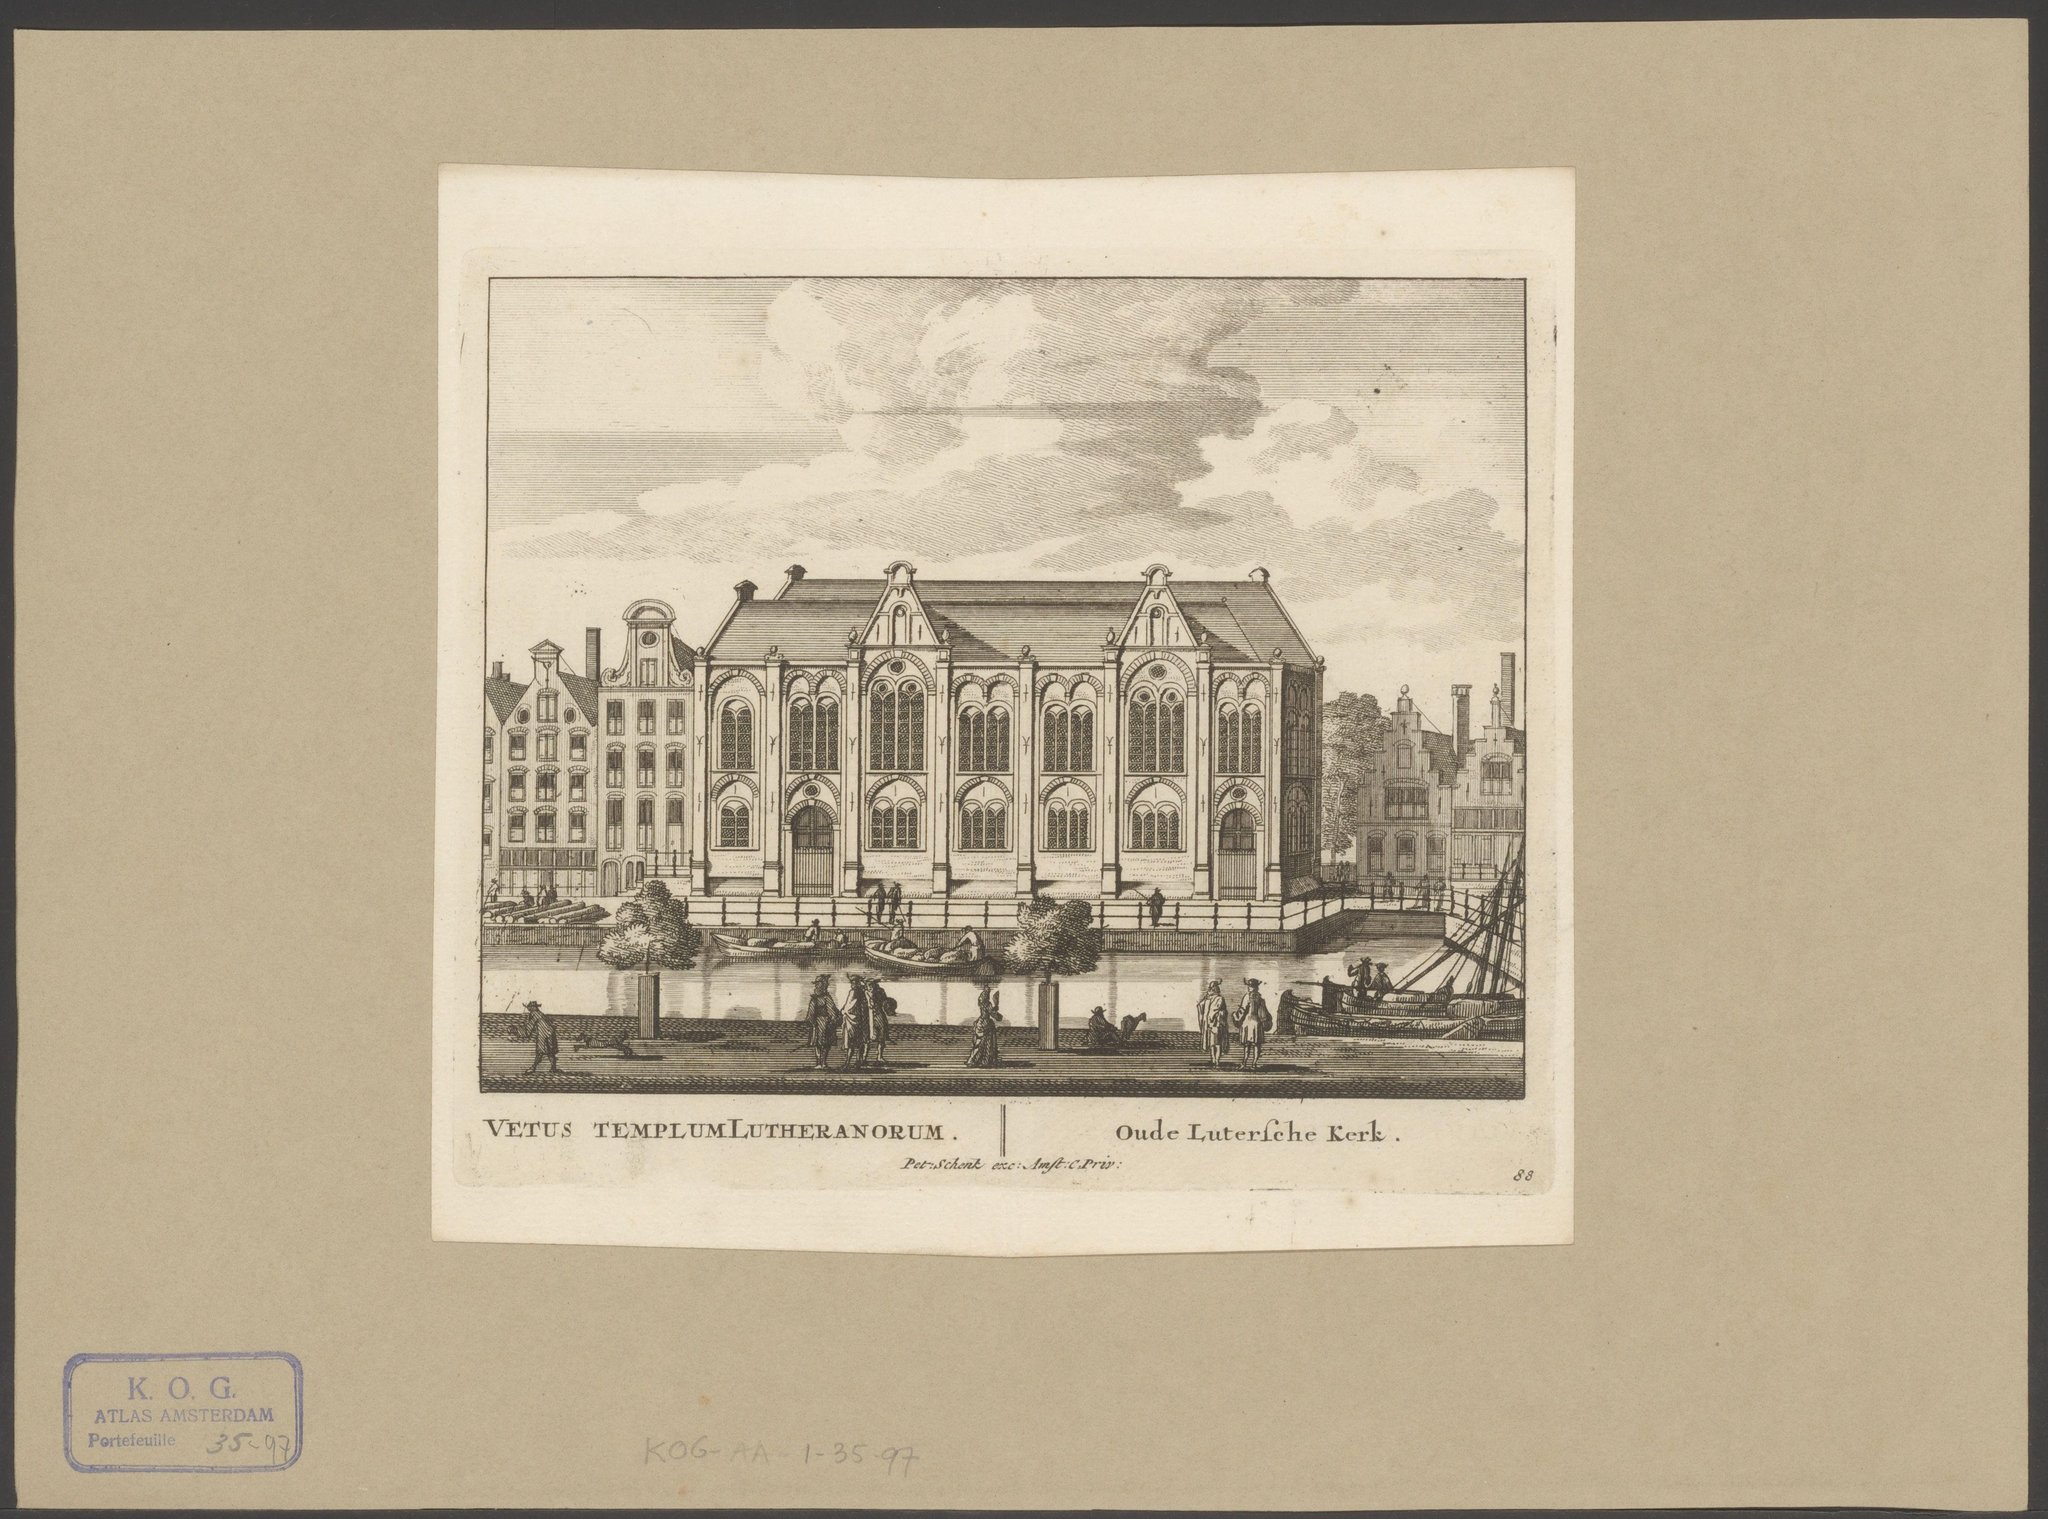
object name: print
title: 100 Afbeeldinge der voornaamste gebouwen van Amsterdam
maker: Anonymous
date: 1710-1711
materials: paper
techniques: engraving, etching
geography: amsterdam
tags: protestant churches and denominations, church (exterior), canals, waters (in city)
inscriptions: collector's mark: ‘35-97’ Lugt 1641b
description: Huidige staat van prent ook gebruikt in: 100 Afbeeldinge der voornaamste gebouwen van Amsterdam. Amsterdam, Pieter Schenk (I), s.a. [1710-1711]. En in: 100 Afbeeldinge der voornaamste gebouwen van Amsterdam. Amsterdam, Barent Greve, s.a. [1757-1766].* *In de tweede uitgave, uitgegeven door Barent Greve, is alleen de titelprent aangepast. De overige prenten zijn onveranderd gebleven.